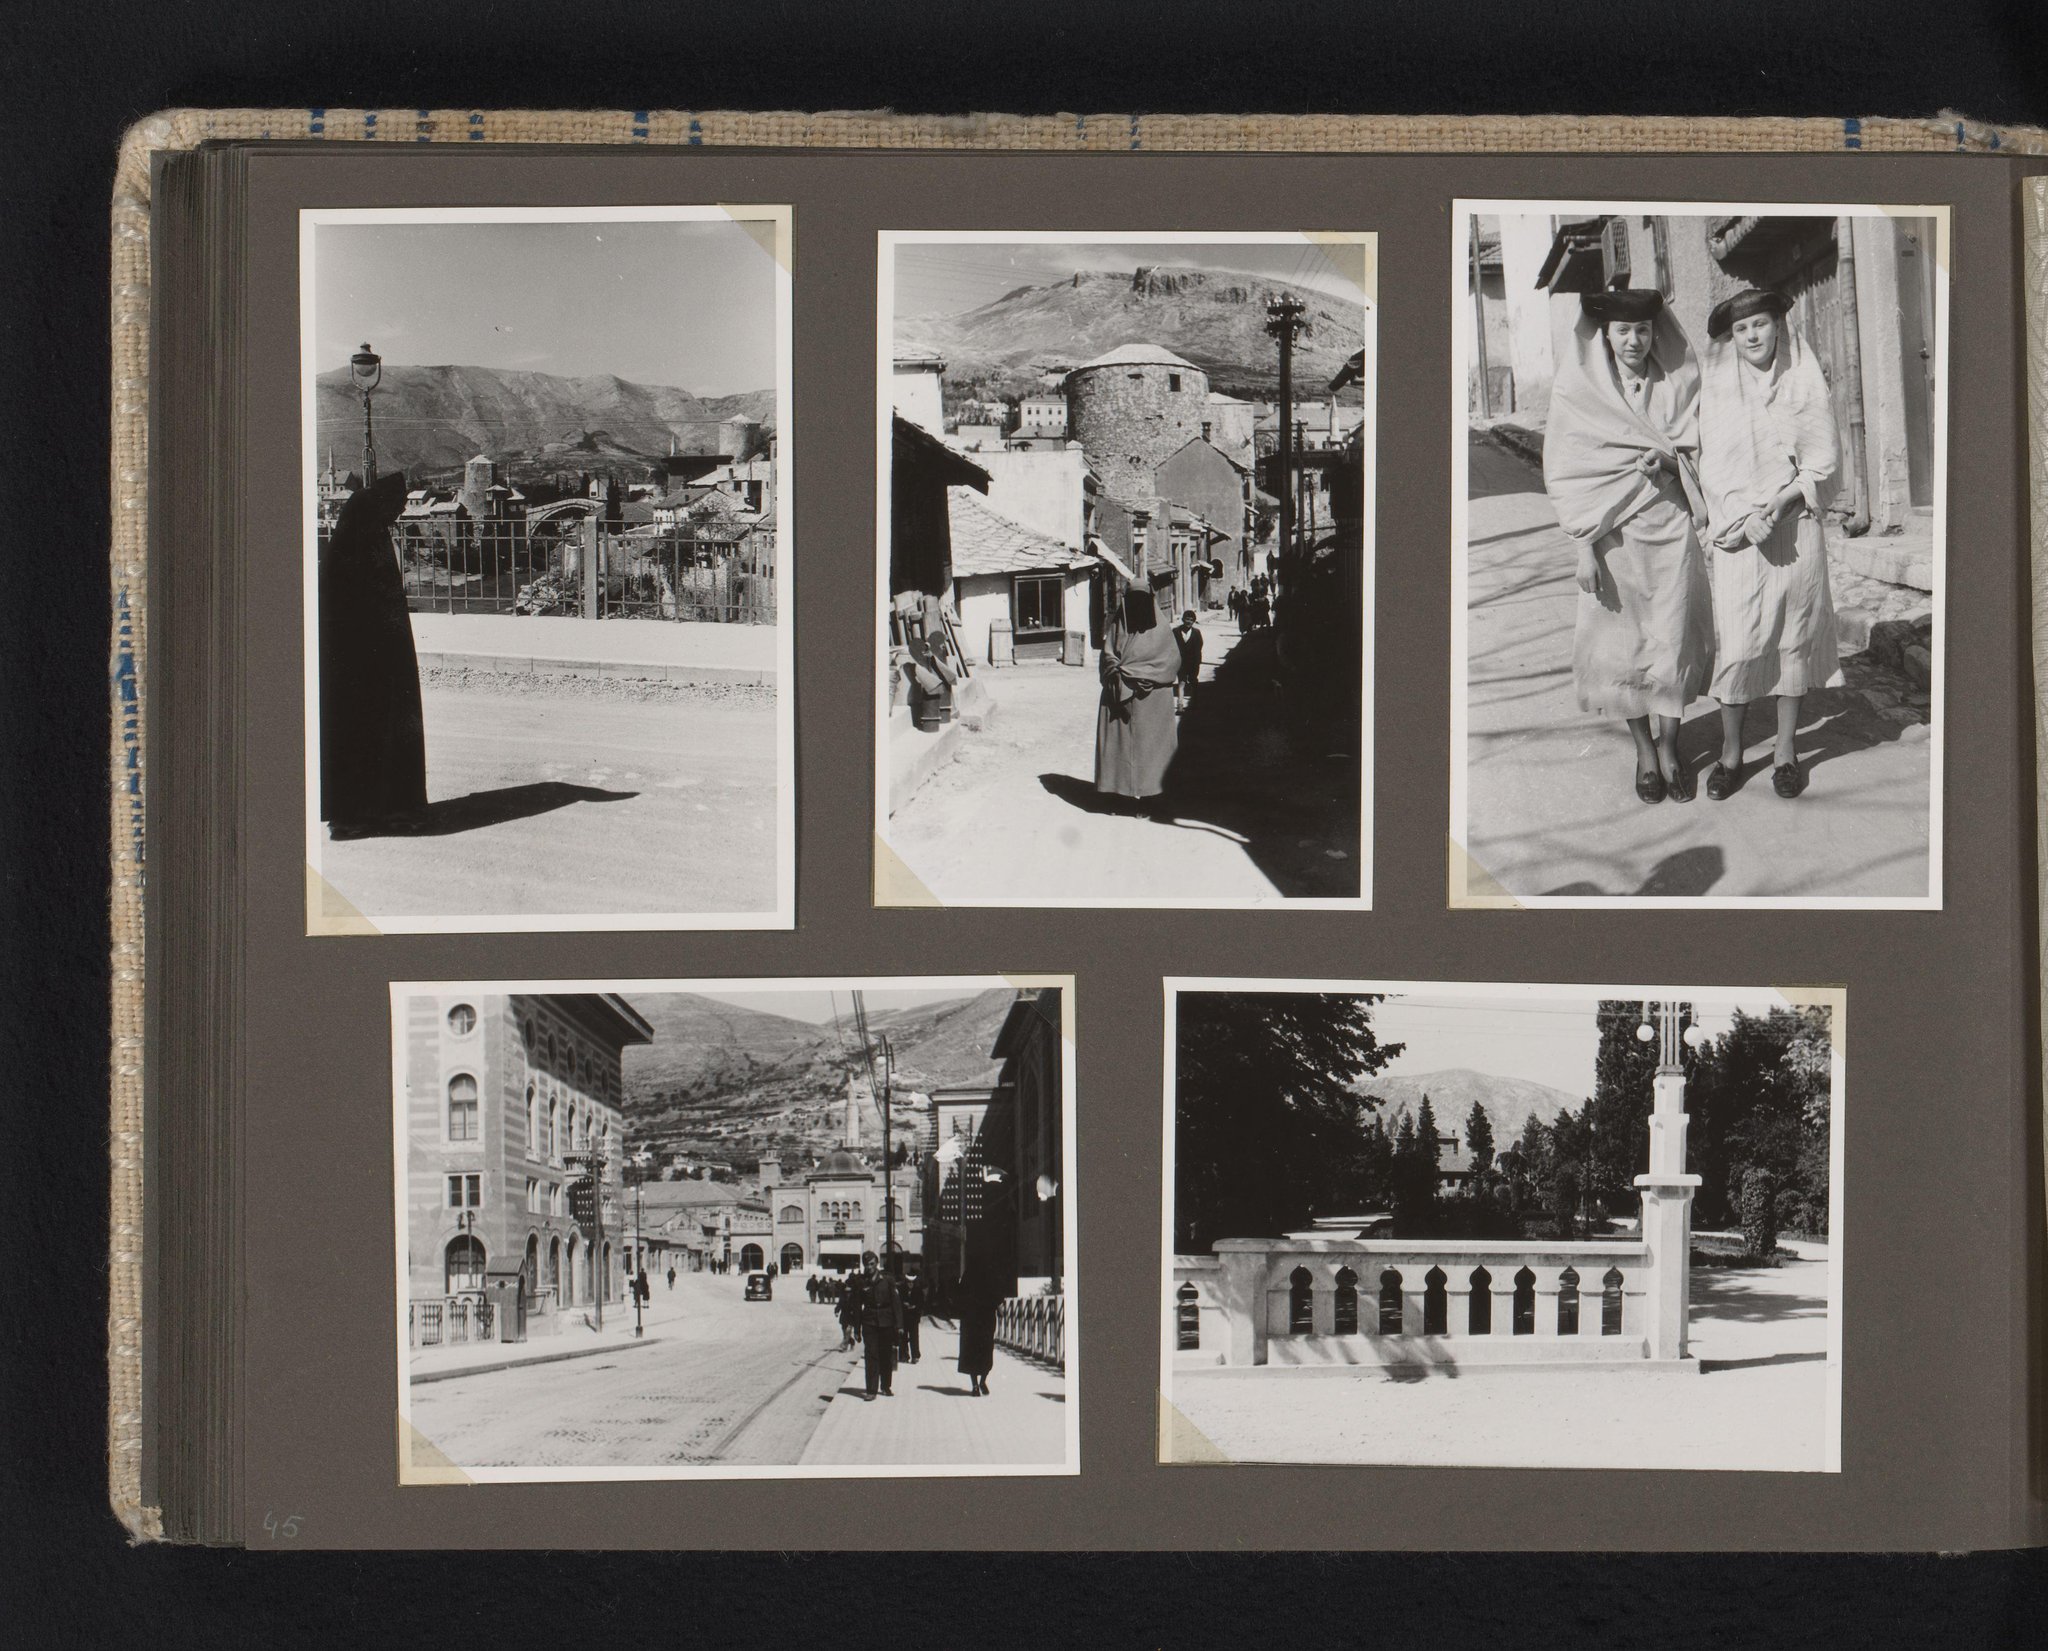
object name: album leaf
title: Mostar in Joegoslavië, april 1943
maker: Anonymous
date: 1904-1943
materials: cardboard, photographic support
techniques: gelatin silver print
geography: mostar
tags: city-view in general; 'veduta', ritual practices ~ islam, mohammedanism, folk costume, regional costume, temple, shrine ~ islam, mohammedanism, bridge in city across river, canal, etc., occupation ~ war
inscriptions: inscription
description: Albumblad met vier foto's gemaakt in Mostar in Joegoslavië, april 1943: straatbeeld met vrouwen in lokale dracht, gesluierde vrouwen en stadsgezicht met de brug Stari Most. Onderdeel van het fotoalbum Abrechnungsintendantur van de Wehrmacht 1941-1943.